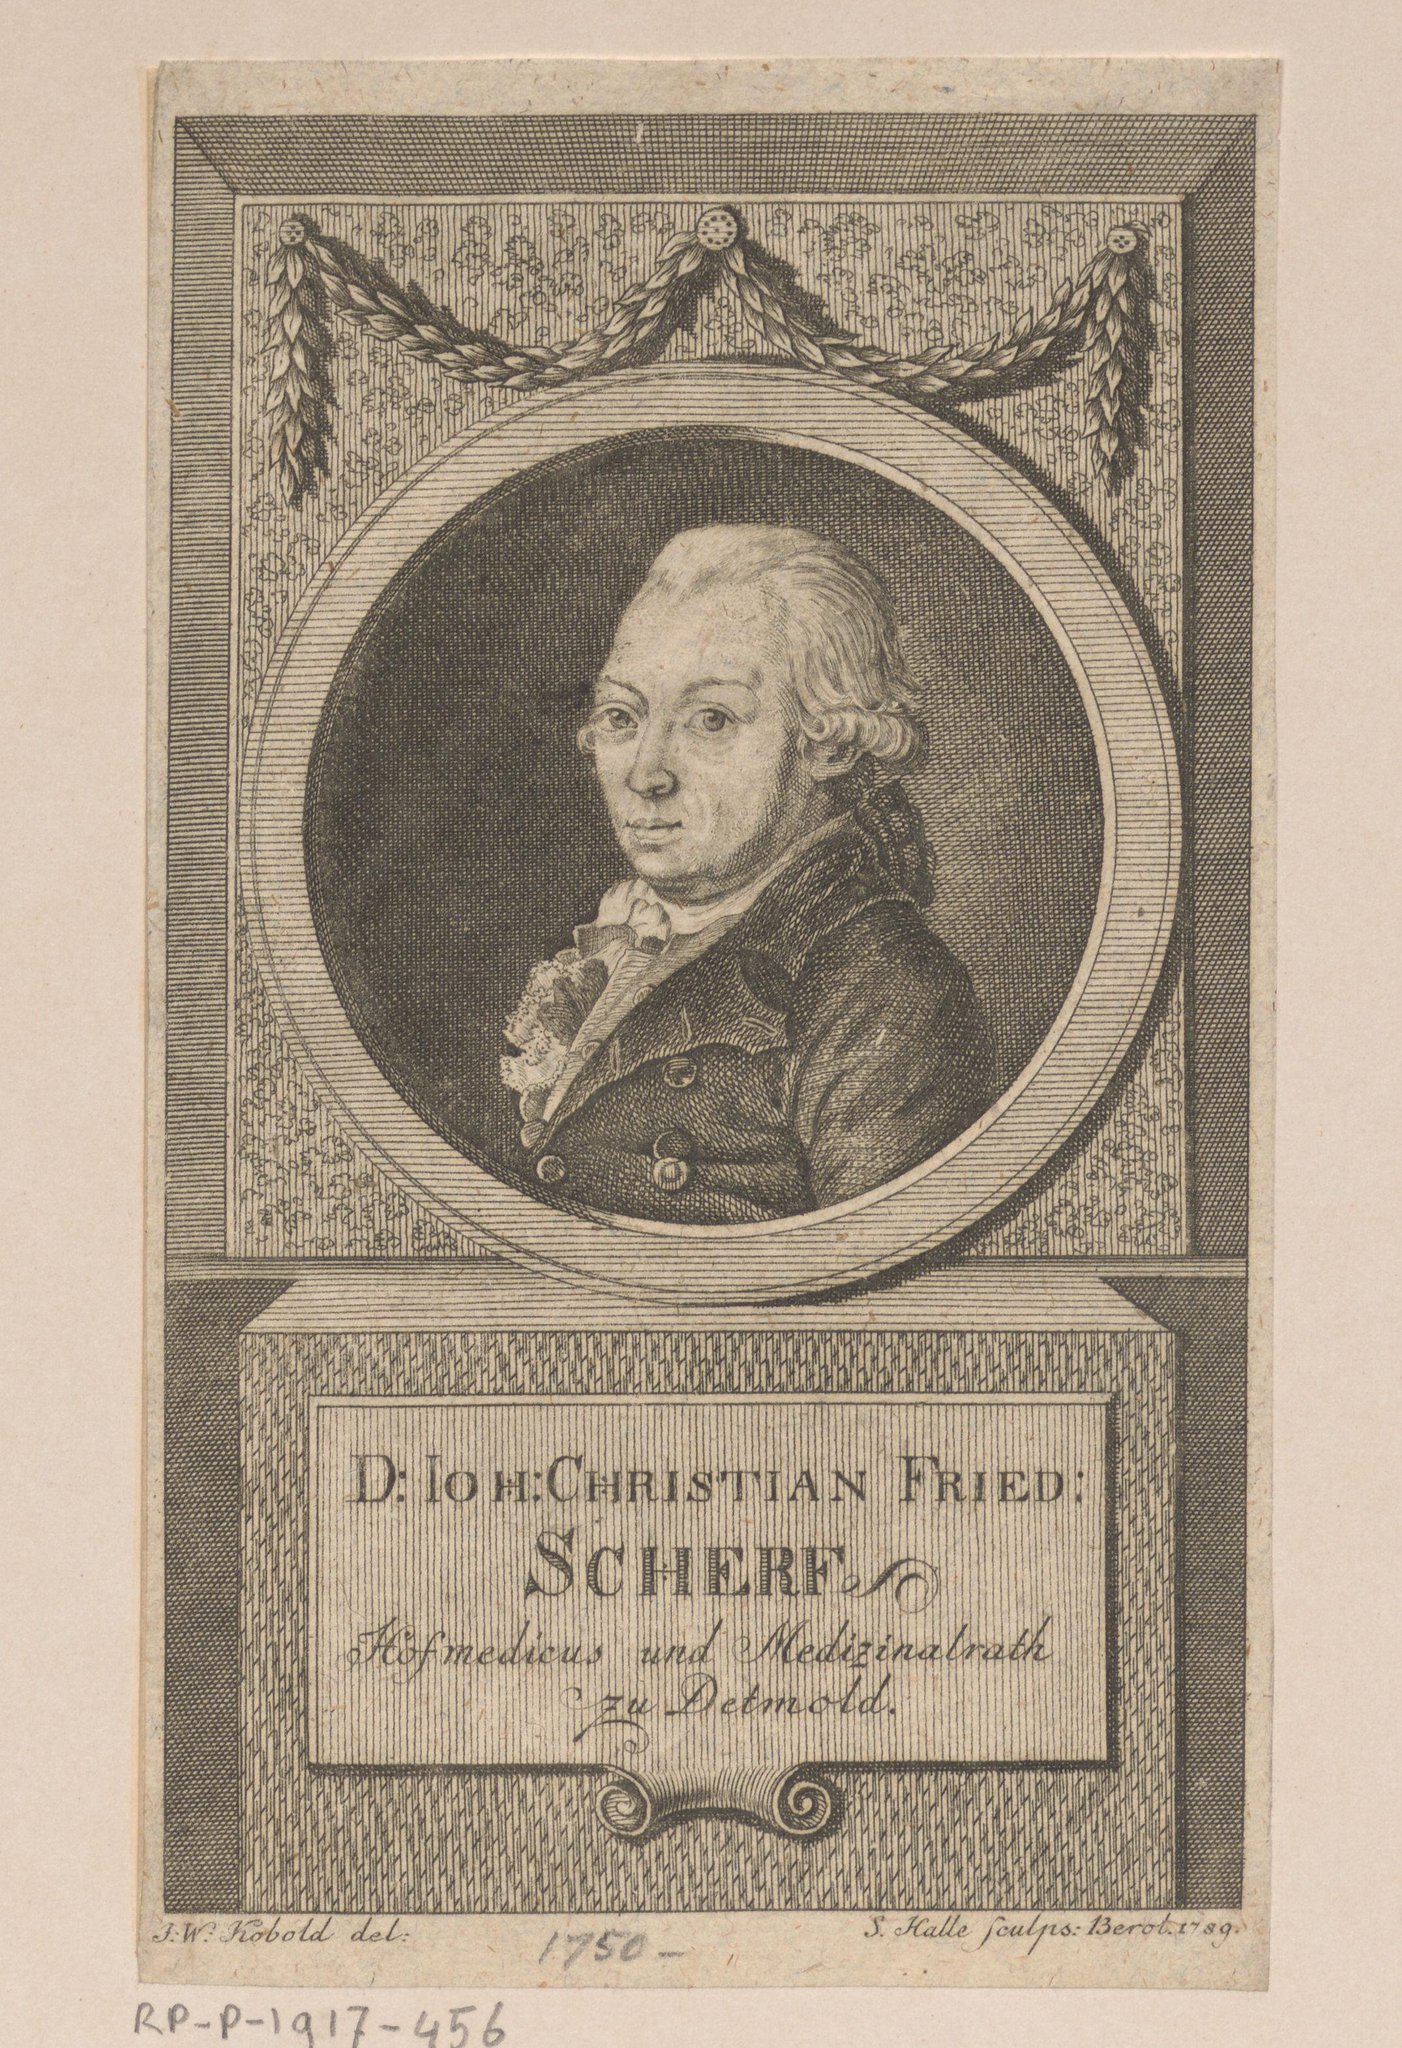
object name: print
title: Portret van Johann Christian Friedrich Scherf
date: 1789-1792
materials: paper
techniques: etching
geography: berlin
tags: historical persons, physician, doctor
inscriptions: collector's mark: Lugt 2228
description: Prent waarschijnlijk uit: Krünitz, Johann Georg. Oeconomische Encyclopädie oder Allgemeines System (...). Berlijn: Joachim Pauli, 1792, dl. 57.